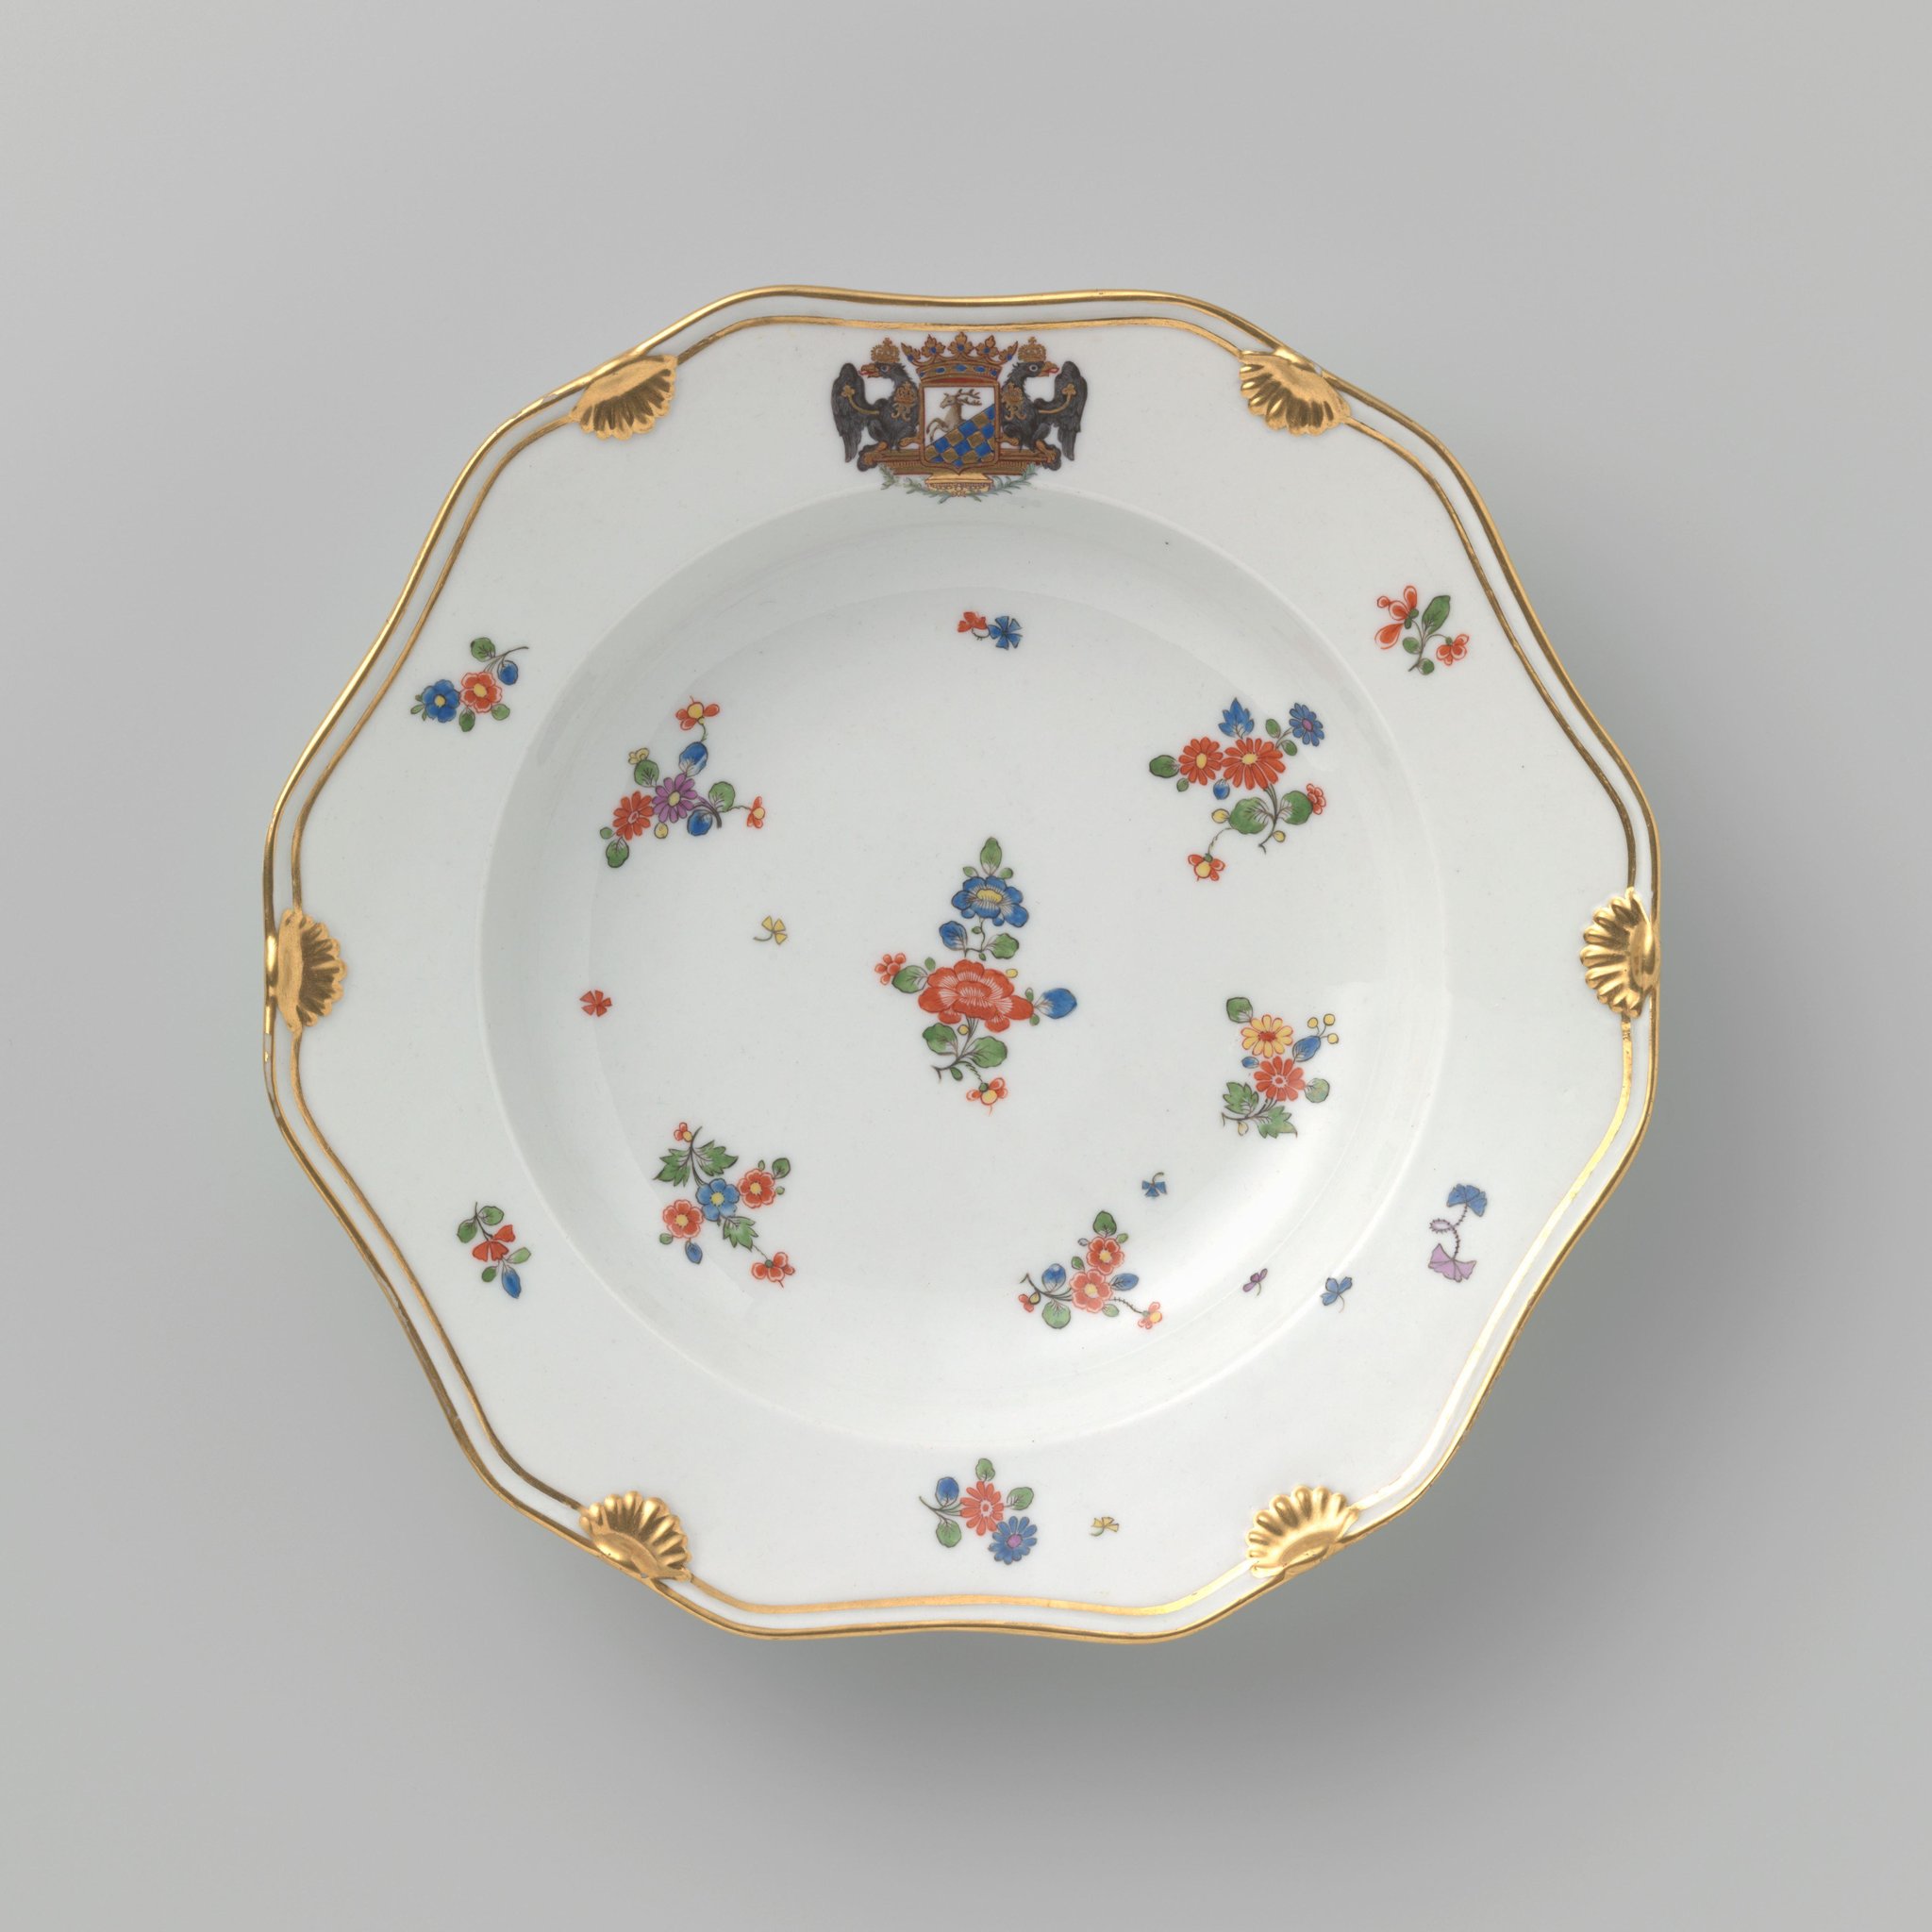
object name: plate dish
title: Plate with the coat of ams of Count Heinrich von Podewils and flower sprays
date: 1763-1800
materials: glaze, gold, porcelain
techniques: firing, forming, gilding, turning, vitrification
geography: berlin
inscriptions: mark: ‘scepter/ 23’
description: Twaalfhoekig bord van porselein, beschilderd op het glazuur in blauw, rood, roze, groen, geel, zwart en goud. Op het plat, de wand en de rand bloemtakken en strooibloemen in de stijl van het Japanse Kakiemon porselein. Het gekroonde wapen van Graaf Heinrich von Podewils (1695-1760) op de rand. Langs de rand een dubbele gouden lijn onderbroken door zes schelpmotieven. De achterzijde met twee strooibloemen. Gemerkt op de onderzijde met de scepter en nummer 23.